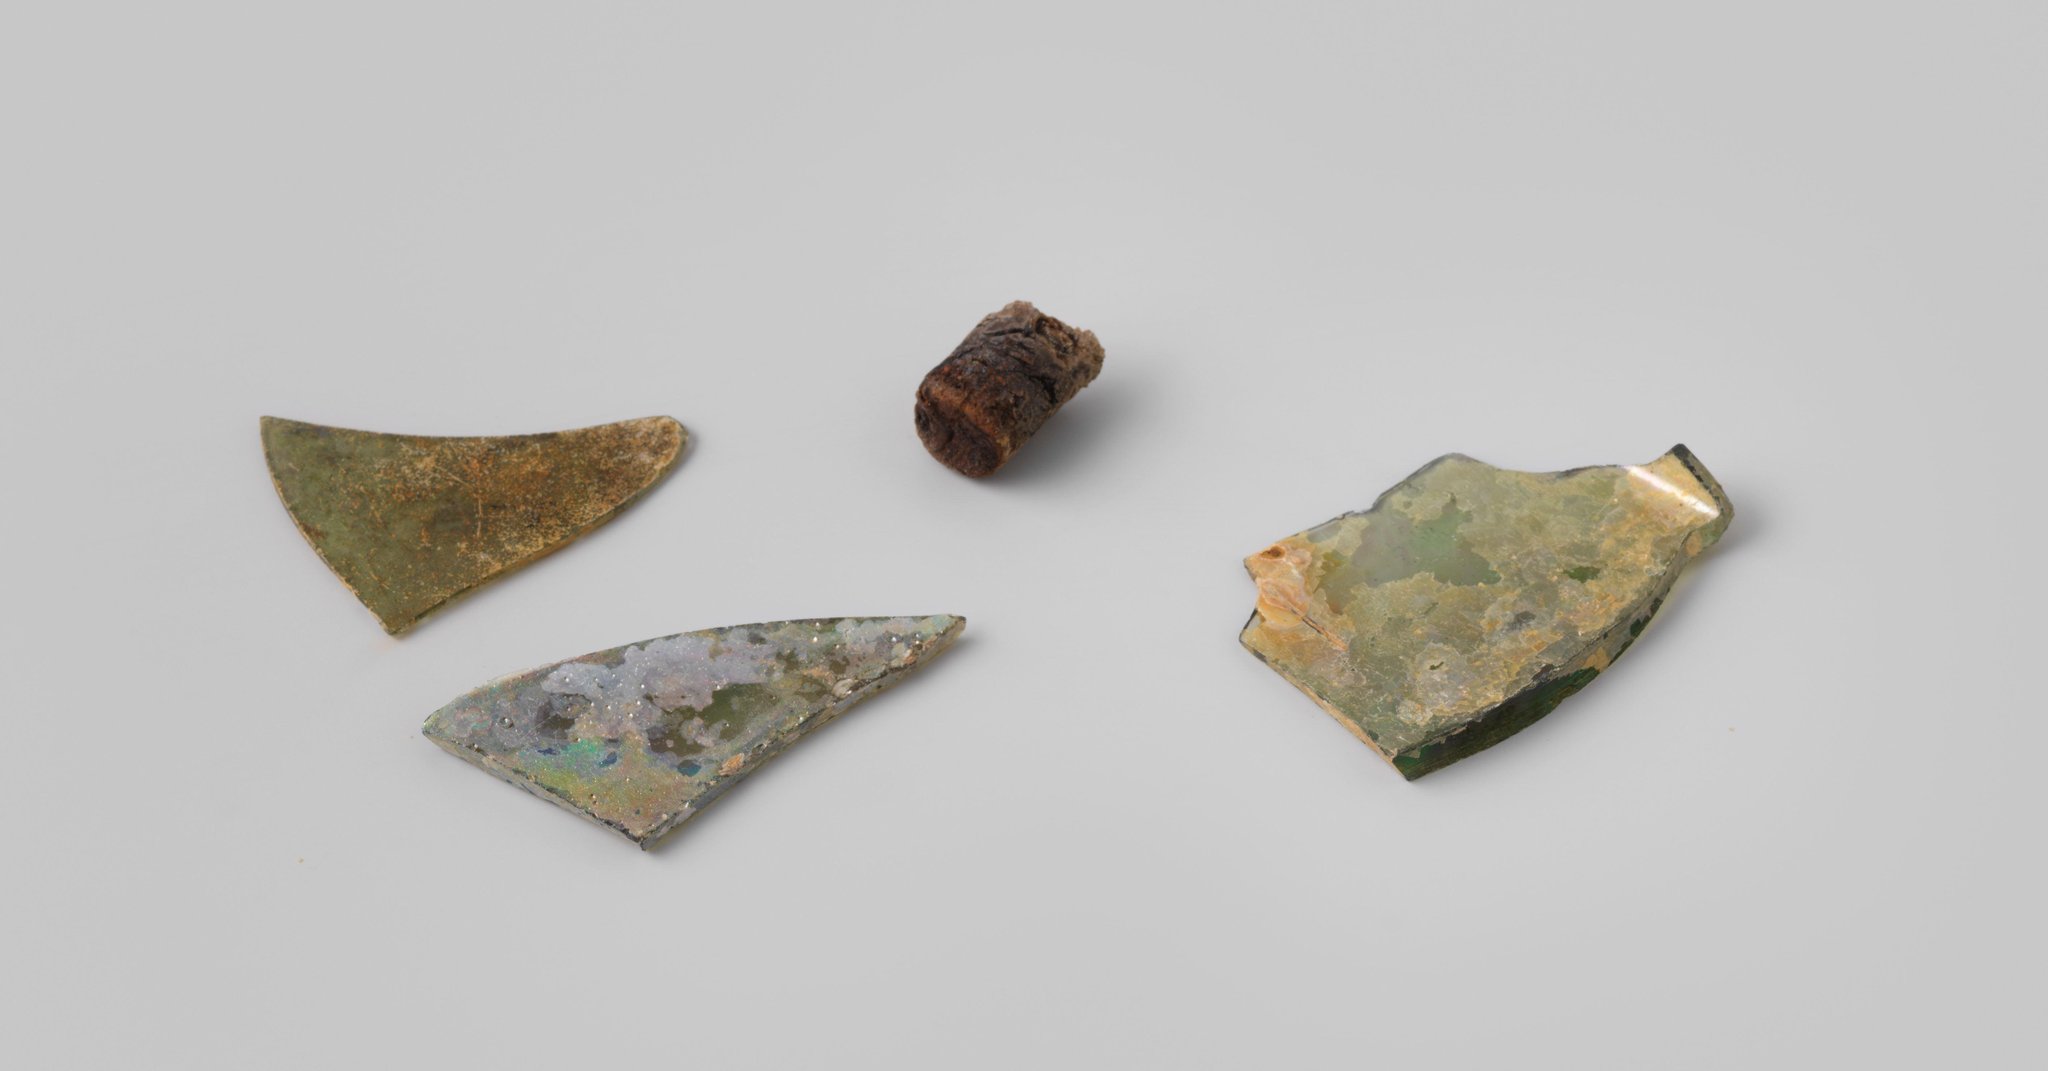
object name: sherd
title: Scherven van wijnflessen en een kurk uit het wrak van de Oost-Indiëvaarder 't Vliegend Hart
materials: cork, glass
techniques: green glass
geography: netherlands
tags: 't vliegend hart (schip), verenigde oostindische compagnie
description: Scherven van uivormige wijnflessen van groen glas waar rode (port)wijn in heeft gezeten en een kurk.